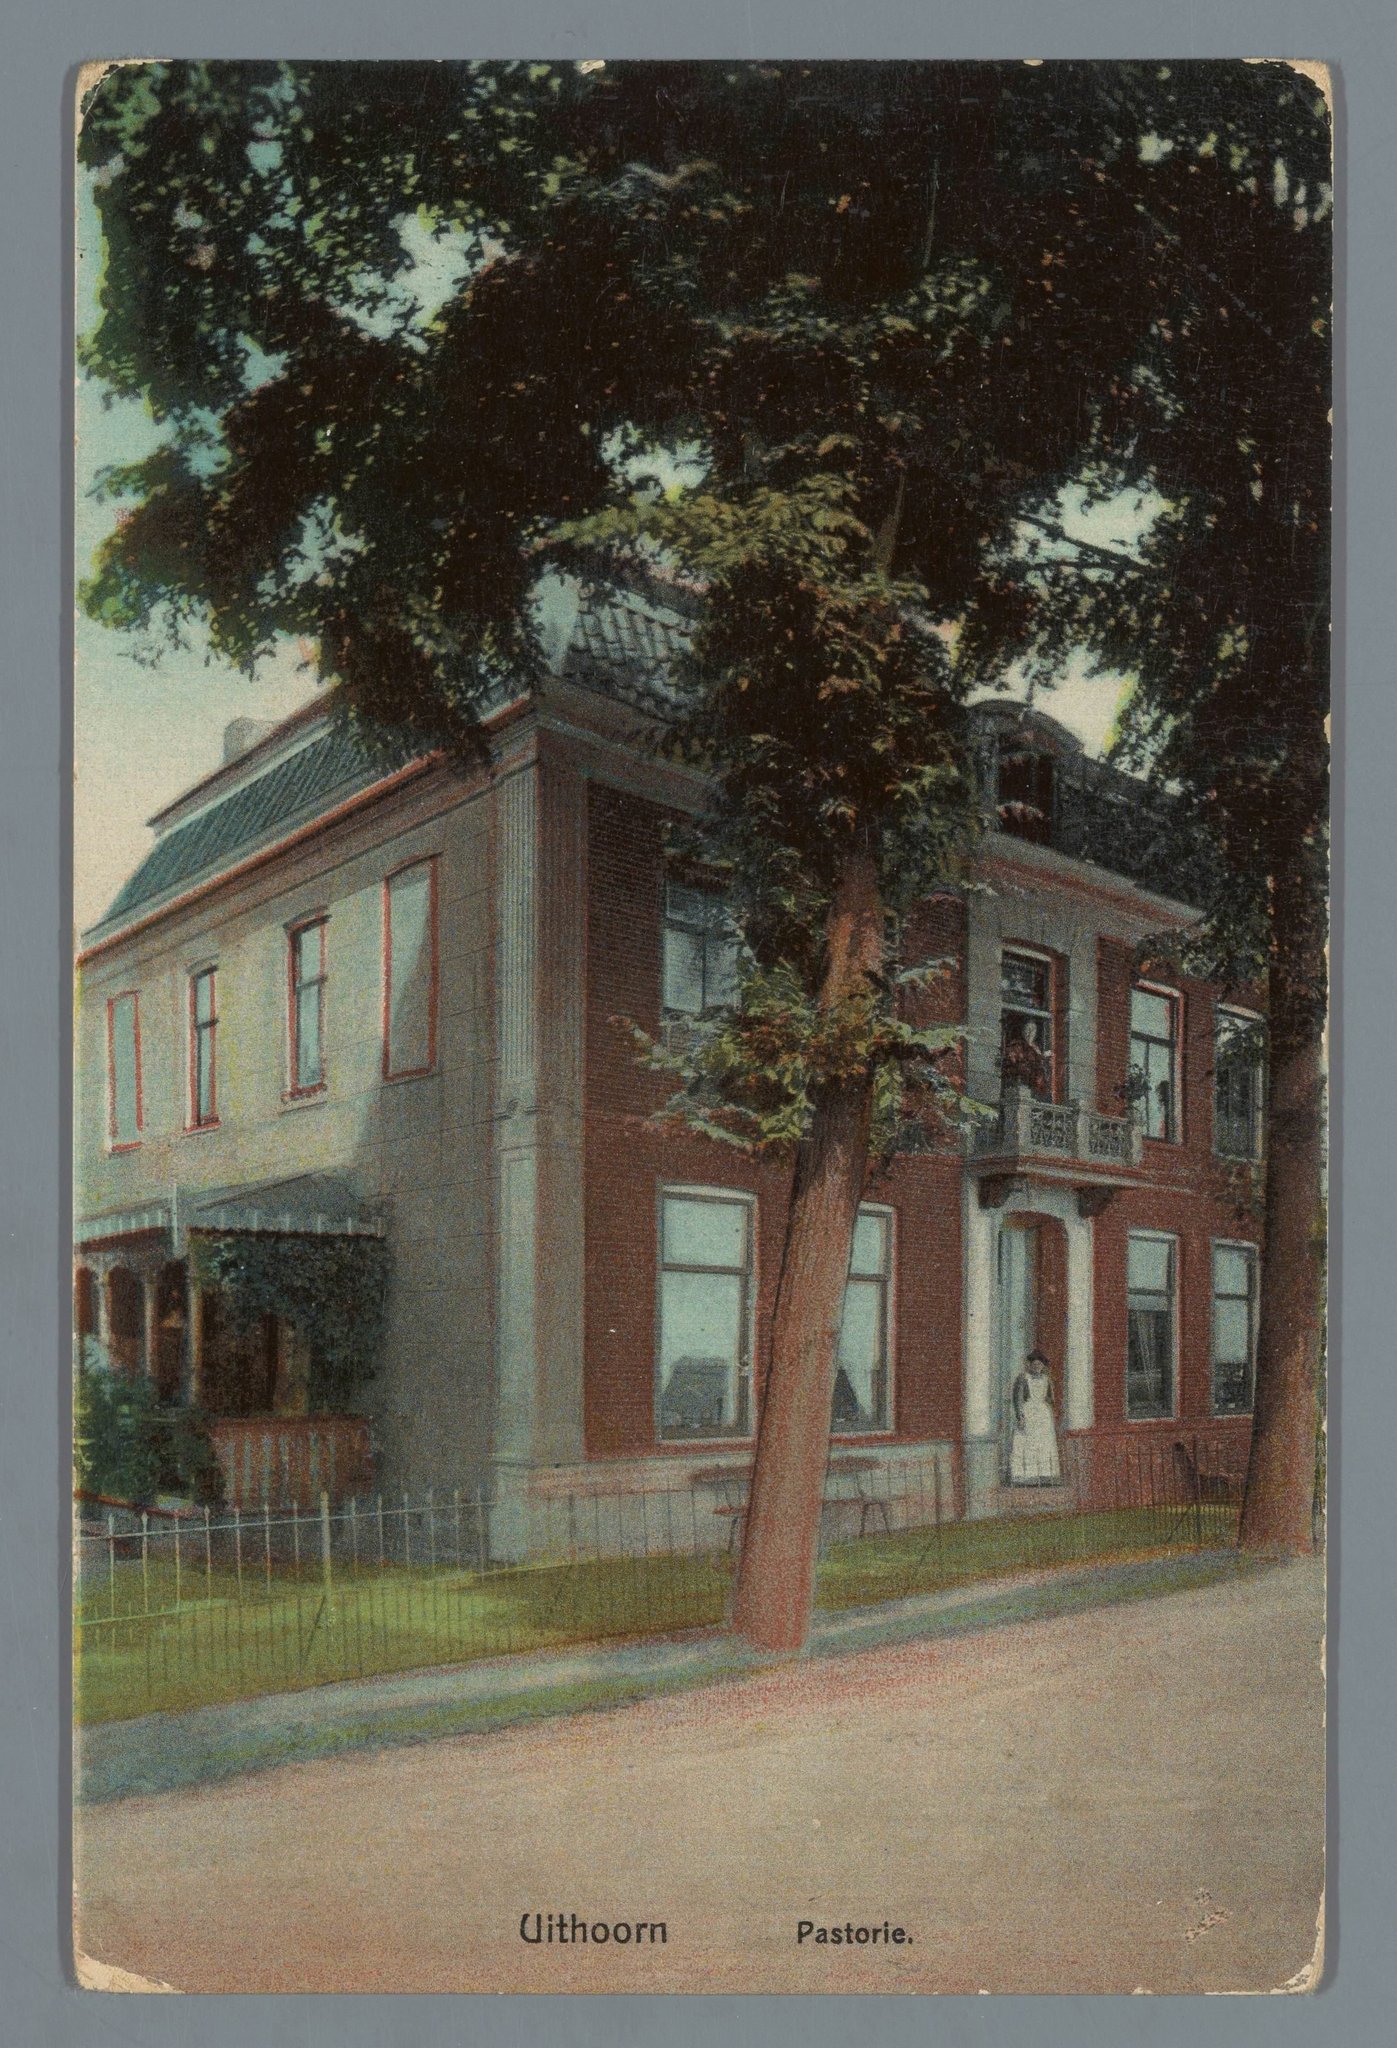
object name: ansichtkaart, prentbriefkaart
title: Uithoorn, Pastorie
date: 1890-1920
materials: cardboard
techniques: photograph, writing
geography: uithoorn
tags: other dwelling types